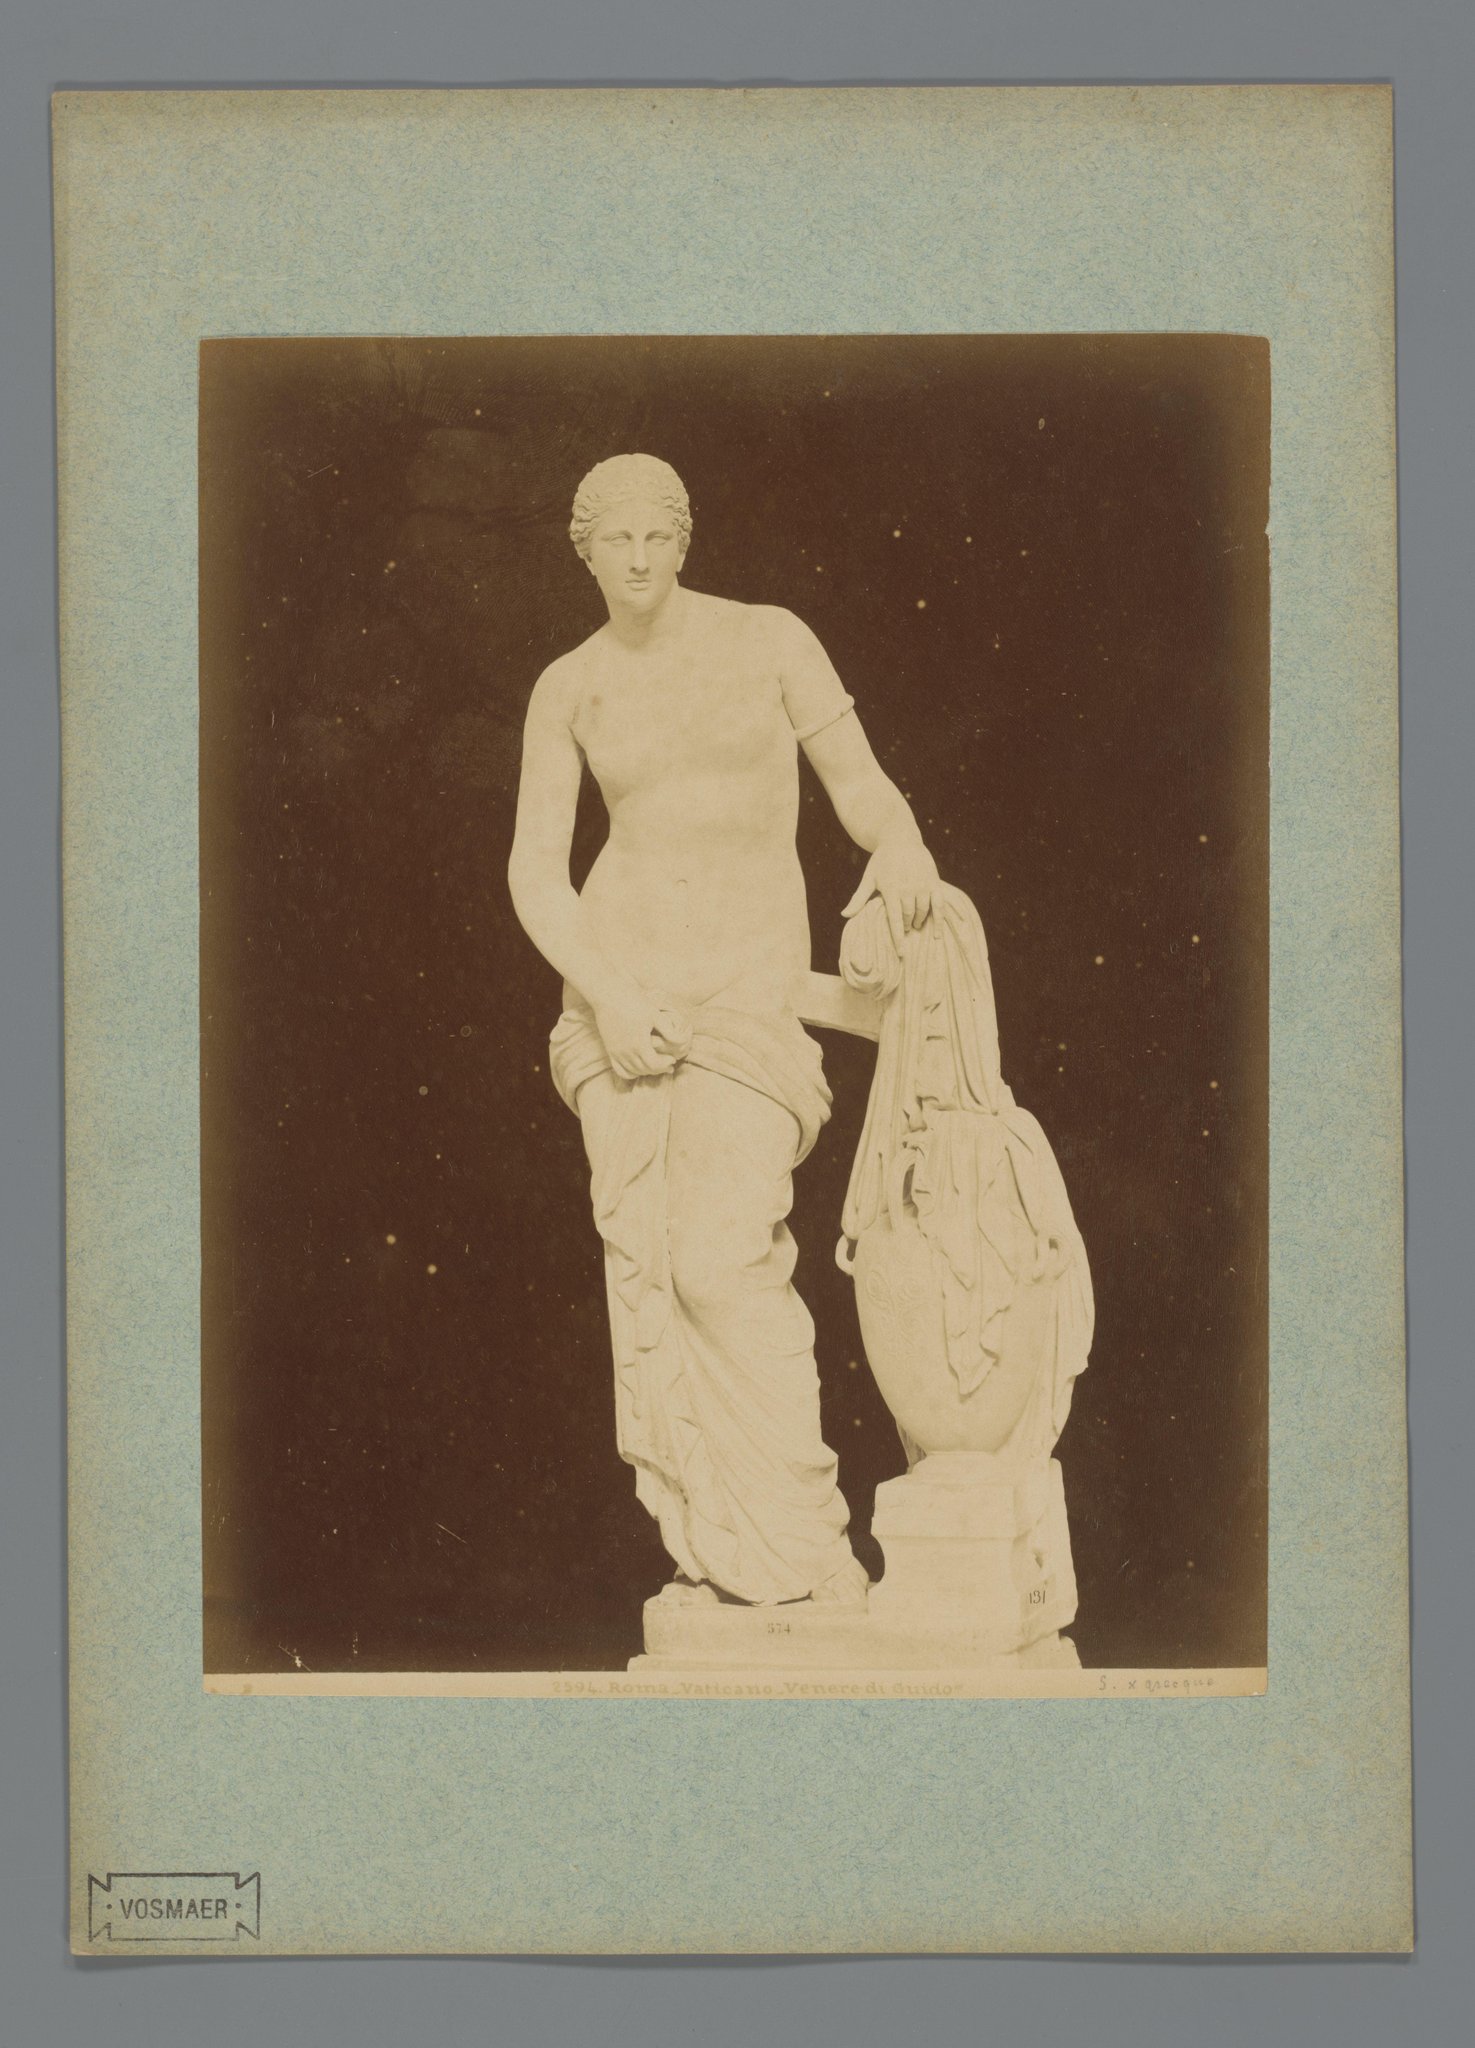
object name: photograph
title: Sculptuur van Venus in de Vaticaanse Musea te Vaticaanstad, Italië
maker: Anonymous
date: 1851-1890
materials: cardboard, paper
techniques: albumen print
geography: vatican city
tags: (story of) venus (aphrodite), sculpture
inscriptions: collector's mark: ‘VOSMAER’, number: ‘2594.’, inscription: ‘5. x Grecque’, number: ‘131’